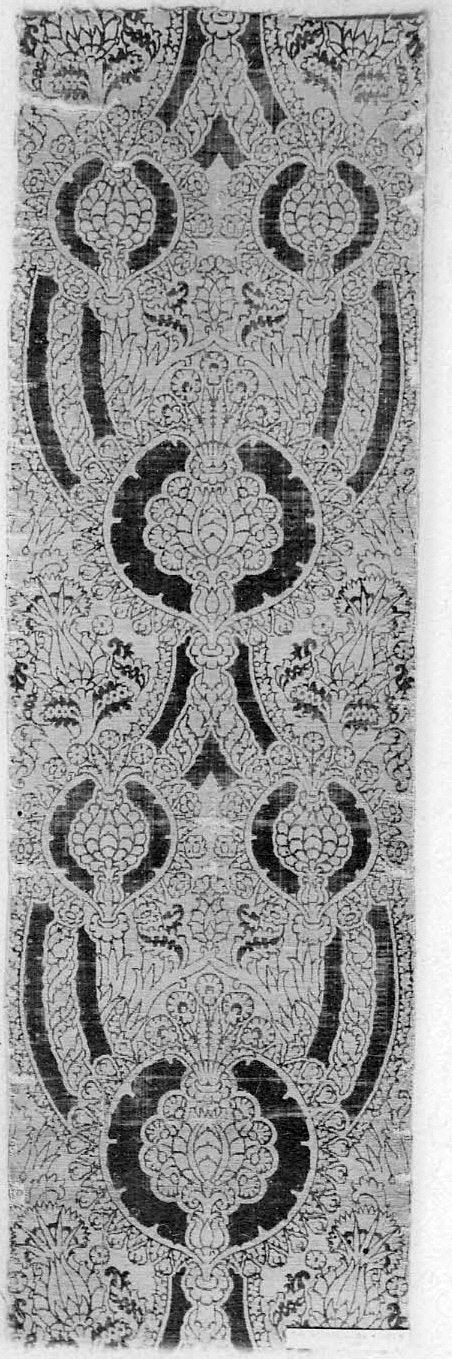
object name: textile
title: Textile with Foliated Scroll and Pomegranate Motives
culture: italian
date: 1401-1500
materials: velvet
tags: pomegranates